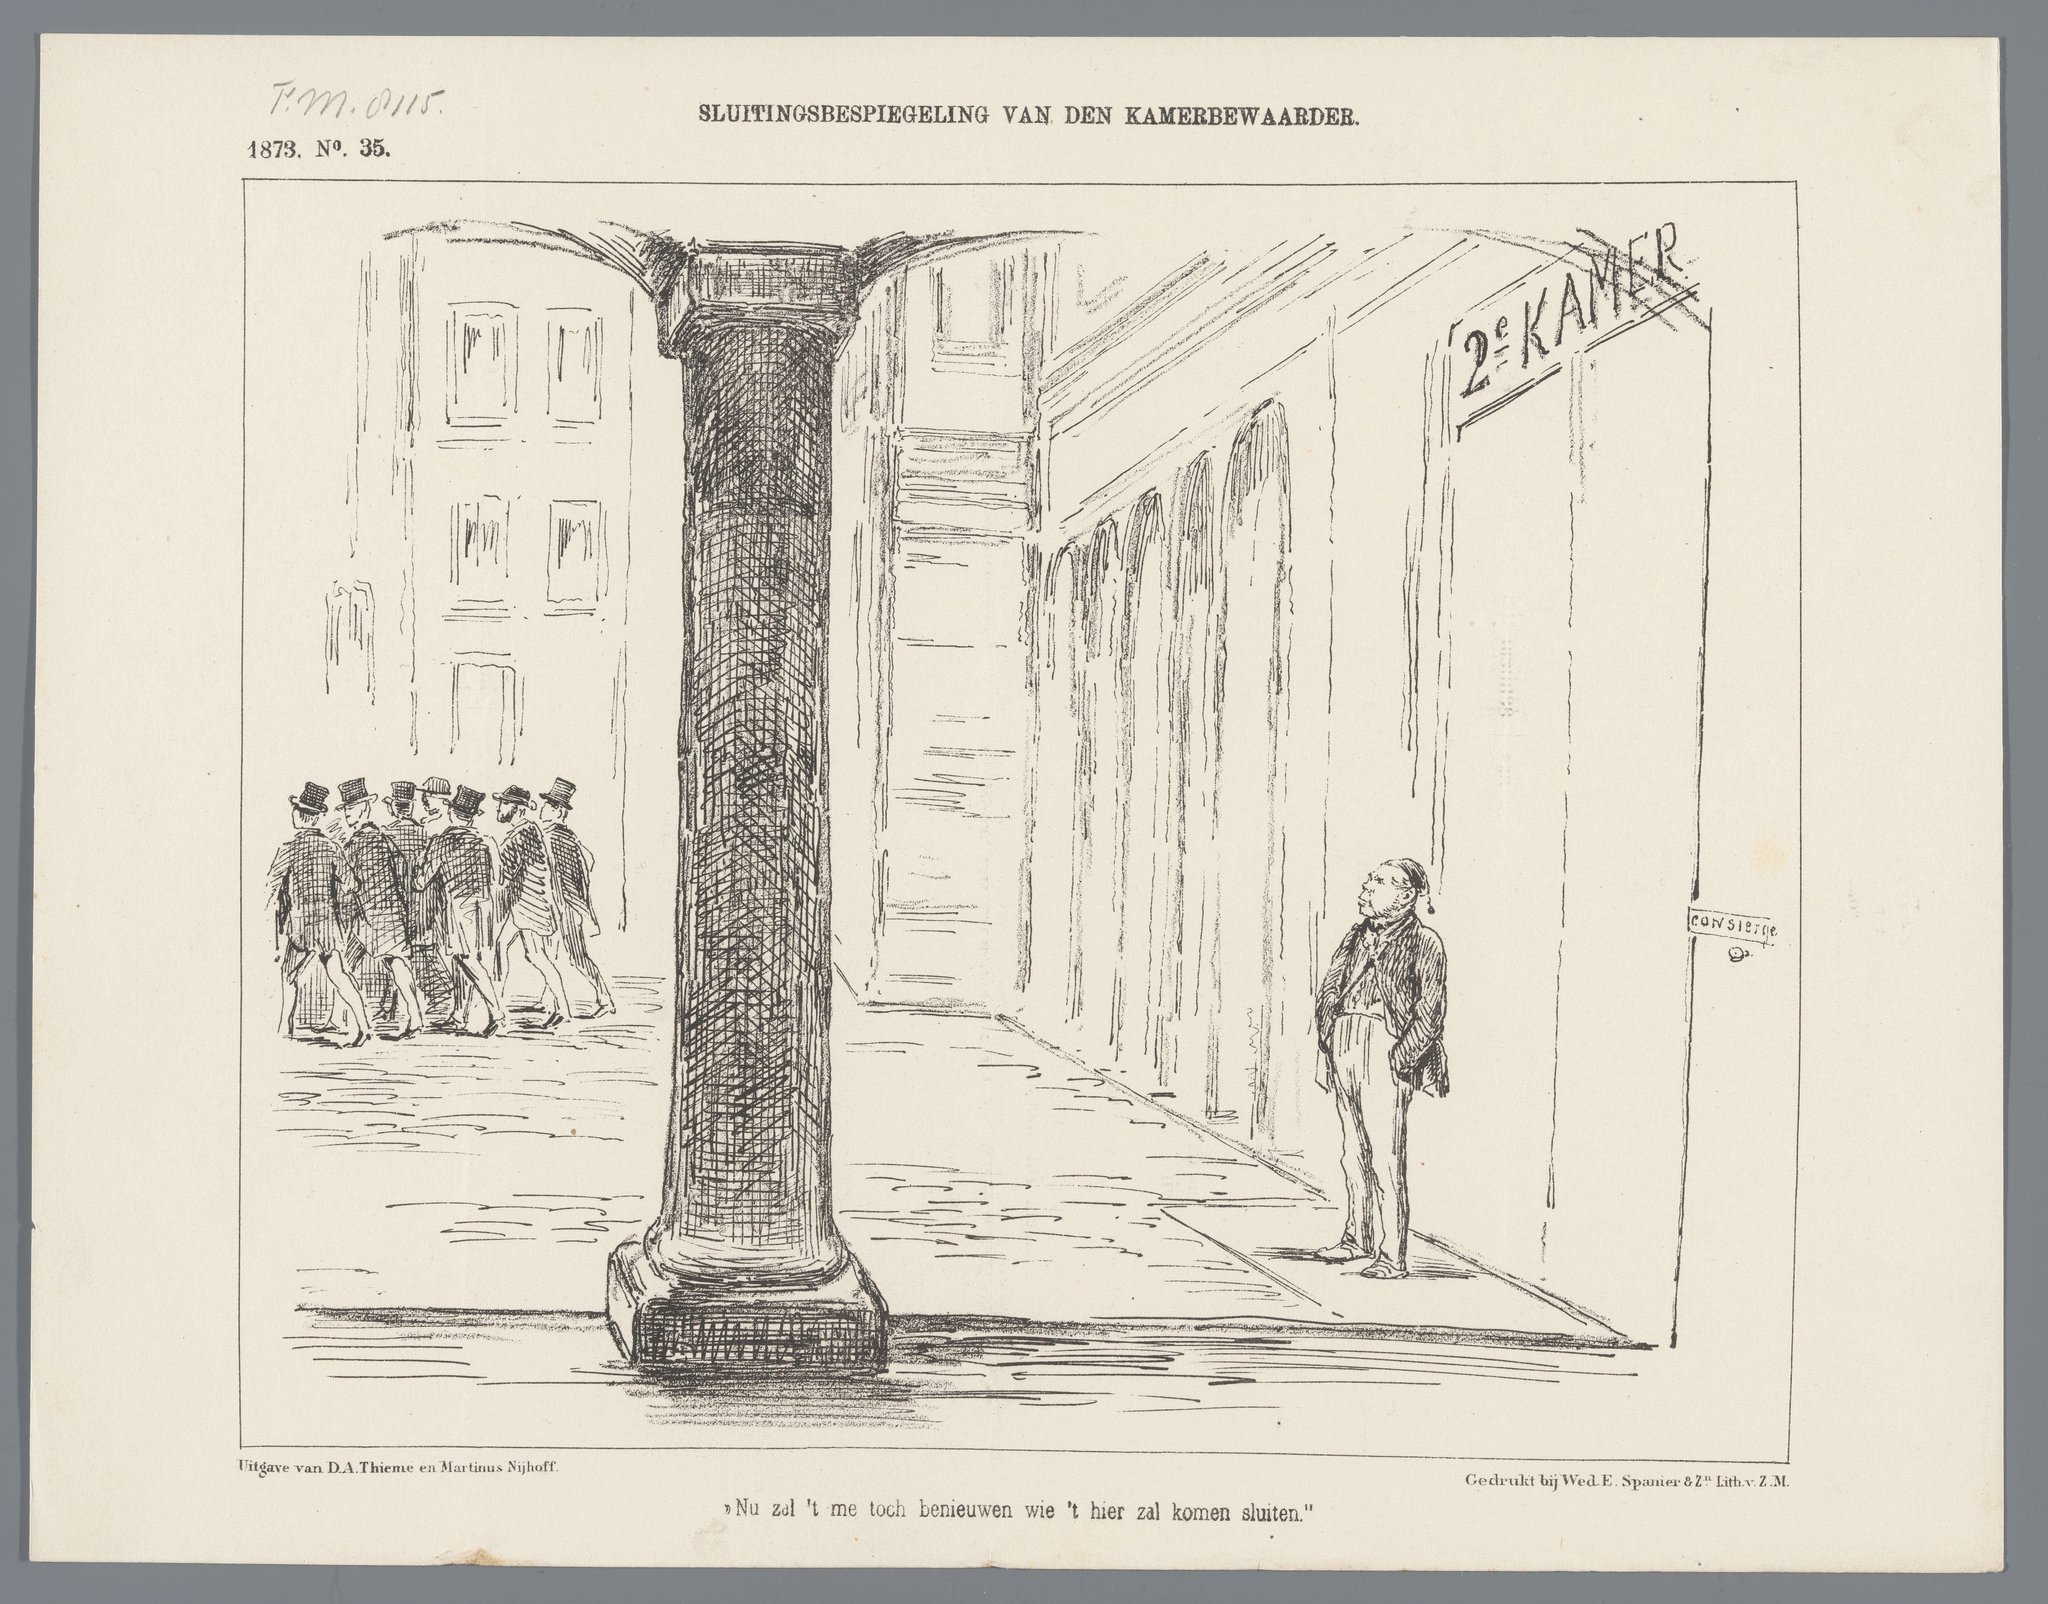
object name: cartoon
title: Spotprent op het aftreden van het ministerie Heemskerk, 1873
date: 1873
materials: paper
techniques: lithograph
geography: netherlands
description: Spotprent op het aftreden van het ministerie Heemskerk vlak voor de sluiting van de Staten-Generaal. Plaat verschenen bij het weekblad De Nederlandsche Spectator, nr. 35, 1873.